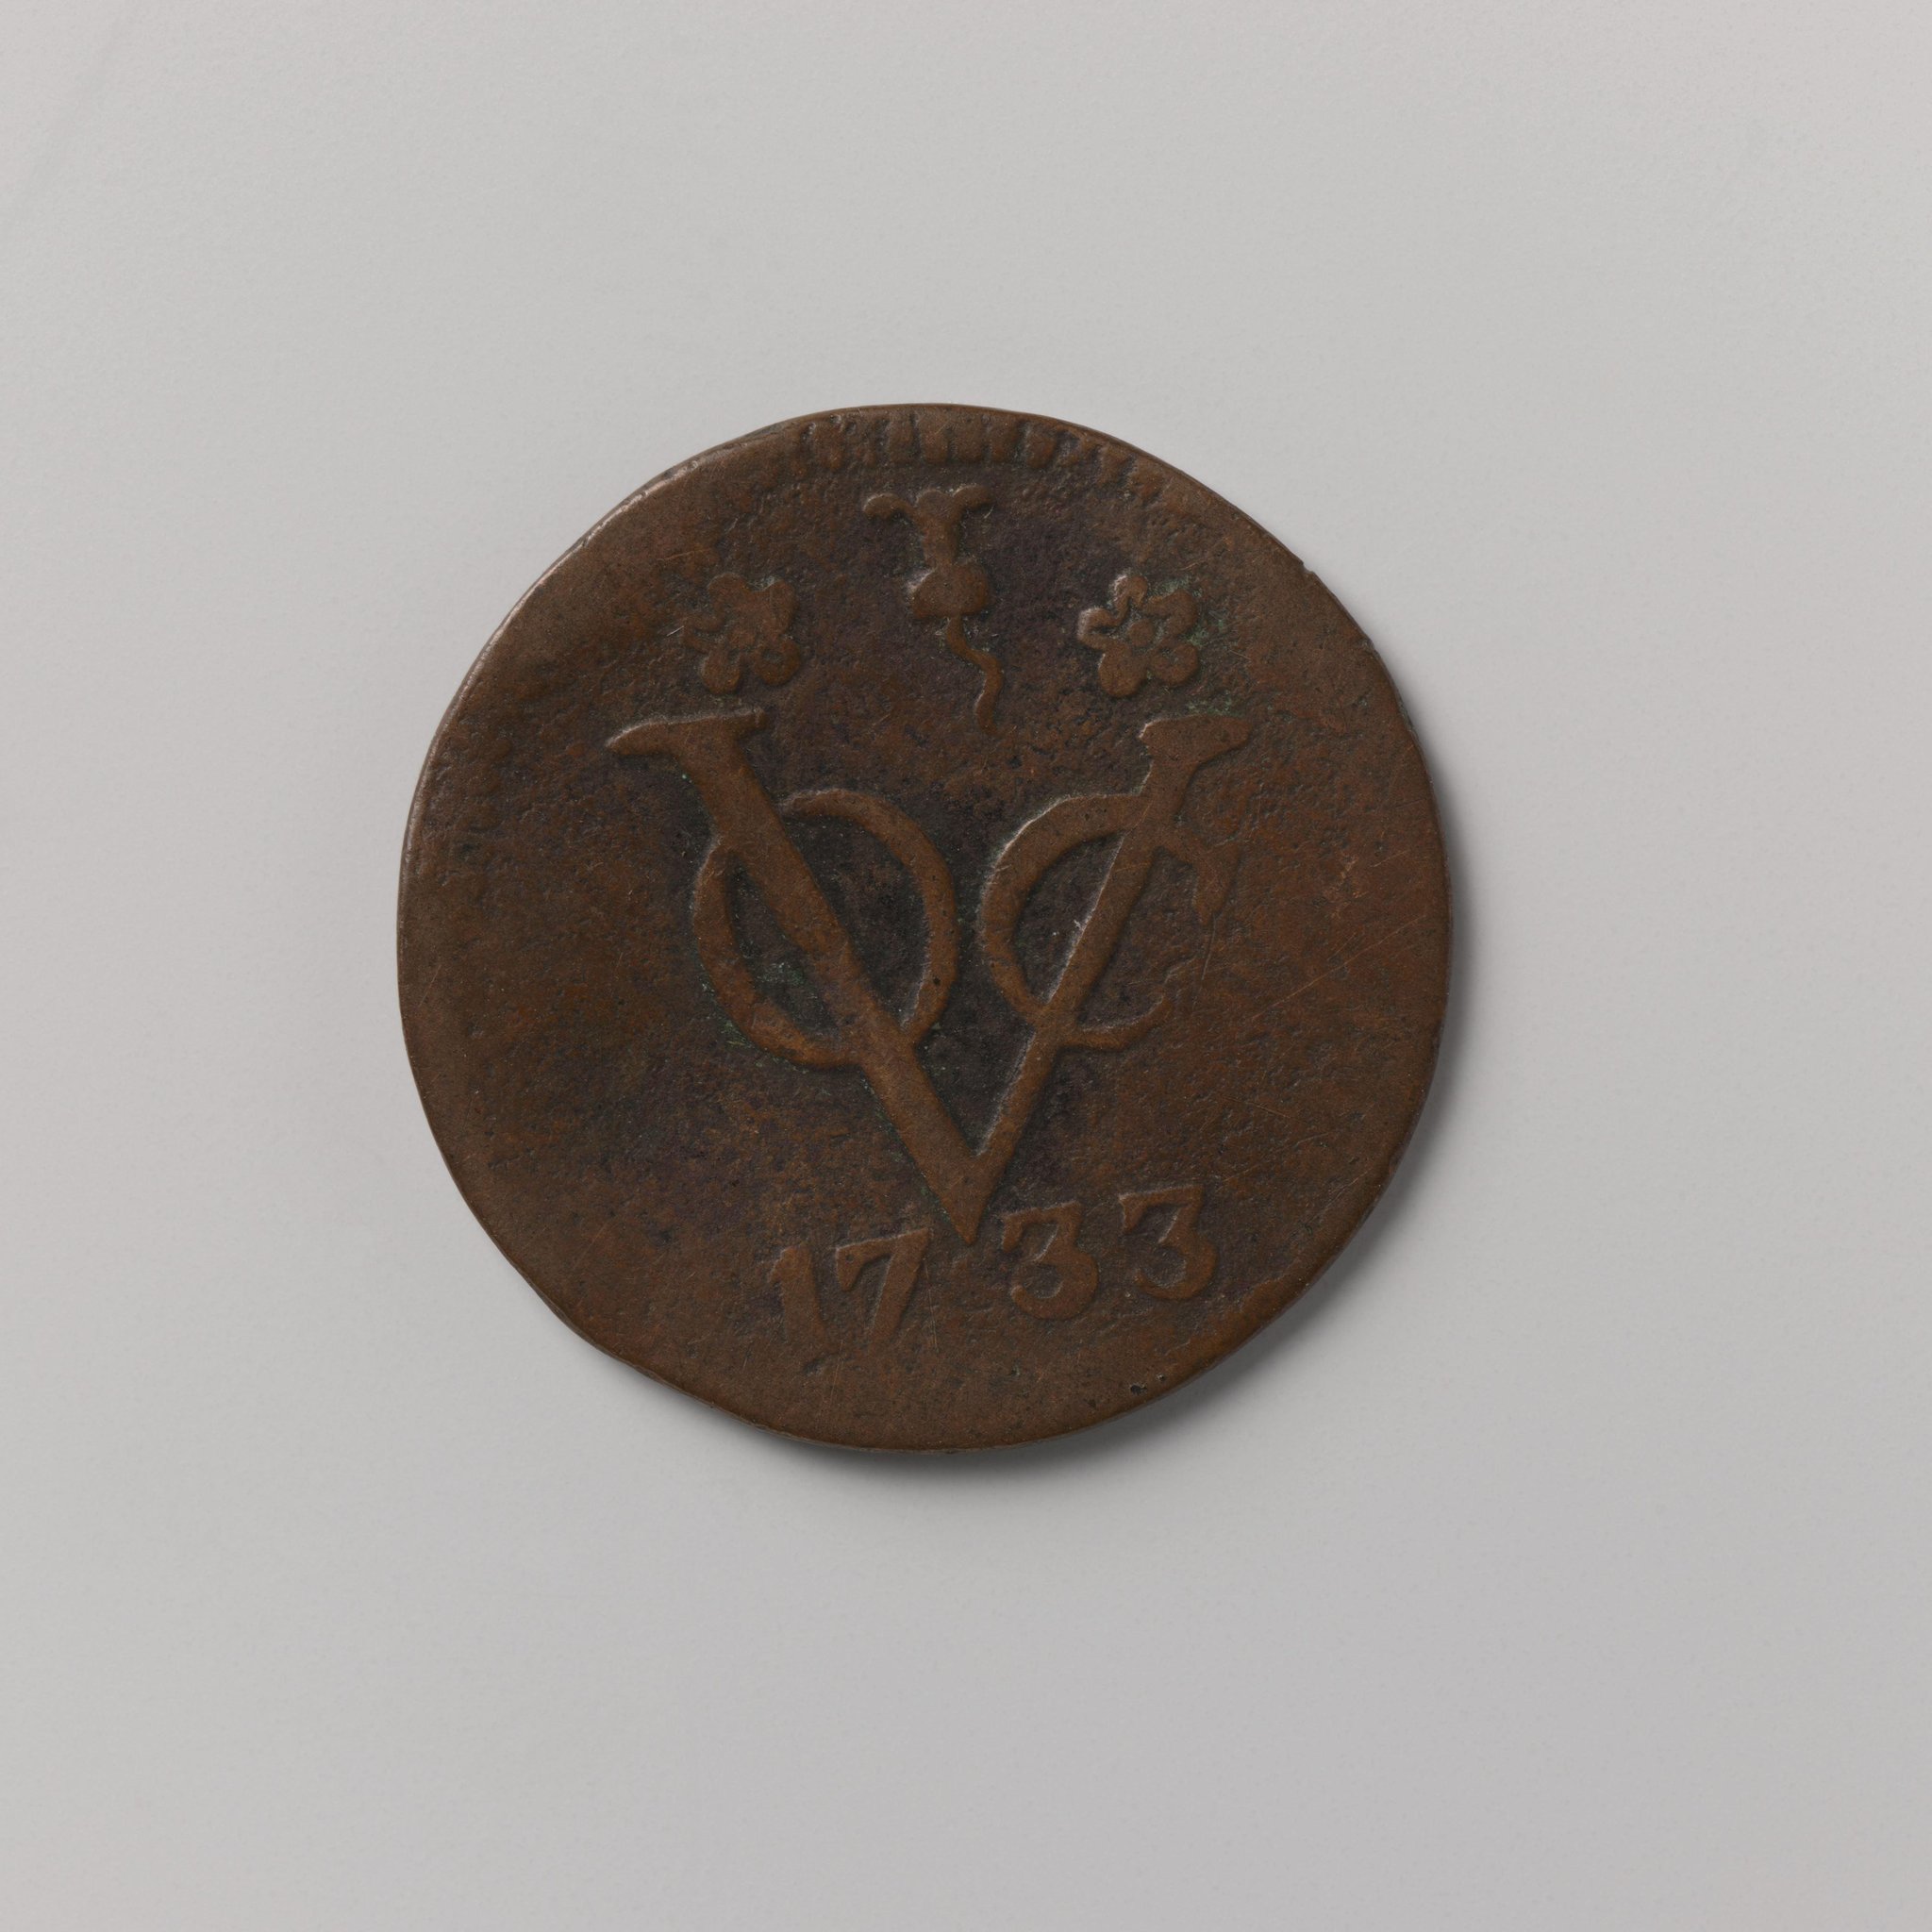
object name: coin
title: VOC, duit Westfriesland, 1733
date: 1733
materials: copper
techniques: striking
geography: enkhuizen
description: Koperen munt. Voorzijde: gekroond wapenschild van Westfriesland. Keerzijde: monogram van de VOC, waarboven muntmeesterteken en waaronder jaartal. Gladde rand.